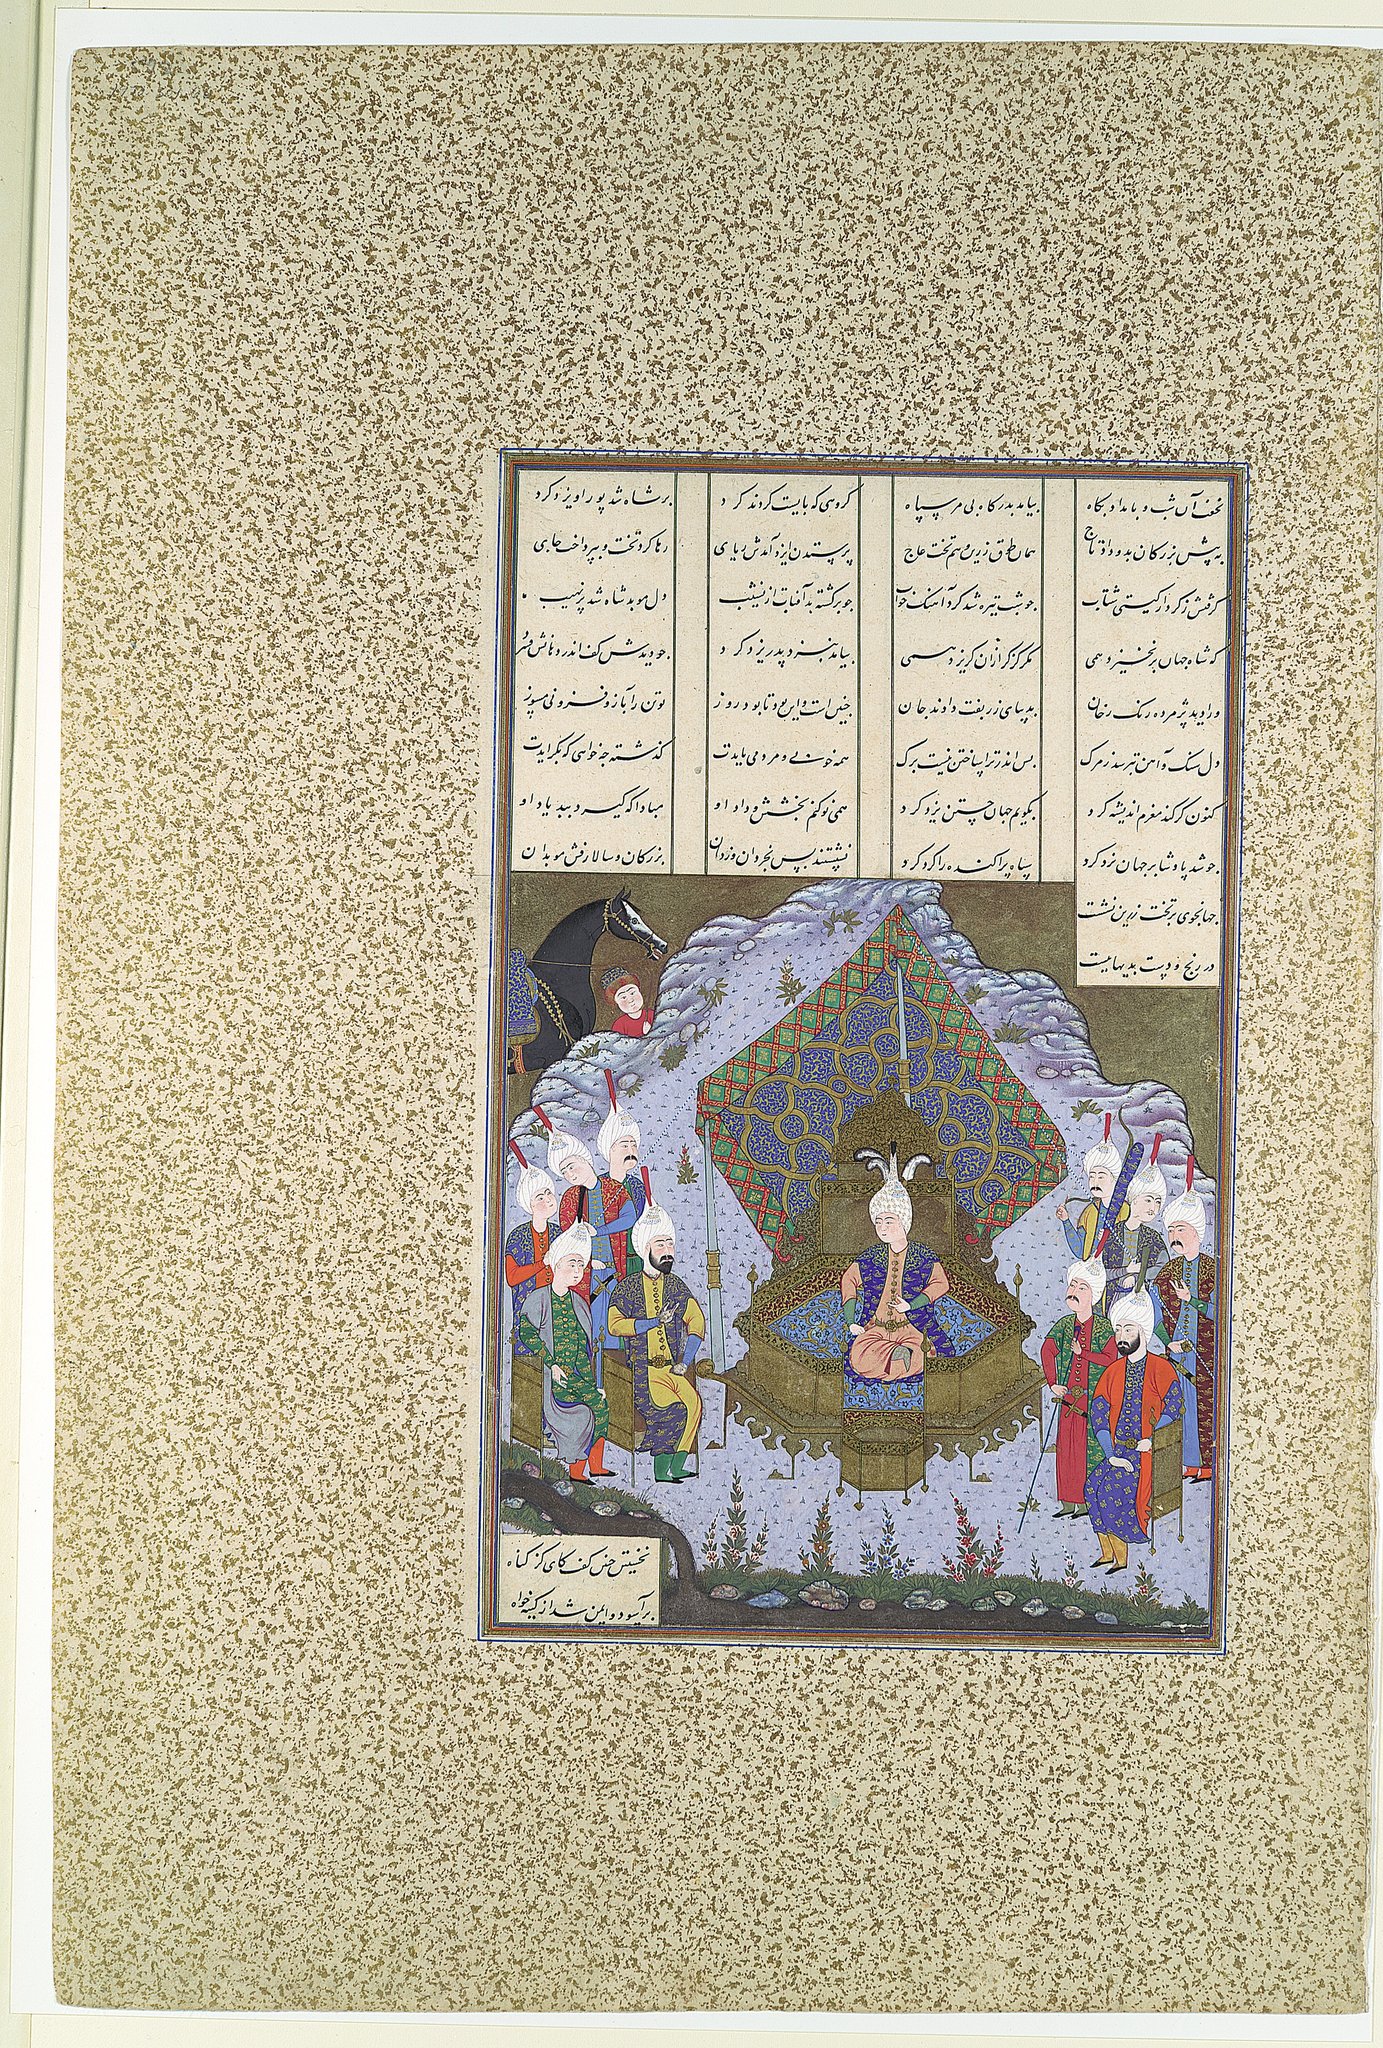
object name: folio from an illustrated manuscript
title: "Yazdigird II Accedes to the Throne", Folio 592r from the Shahnama (Book of Kings) of Shah Tahmasp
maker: abu'l qasim firdausi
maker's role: author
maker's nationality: iranian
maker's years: 935-1020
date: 1530-1535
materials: gold, ink, paper, silver, watercolor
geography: iran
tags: men,horses